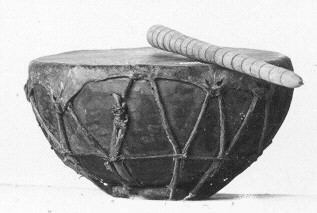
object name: naqqareh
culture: syrian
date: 1867-1900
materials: brass, parchment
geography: syria